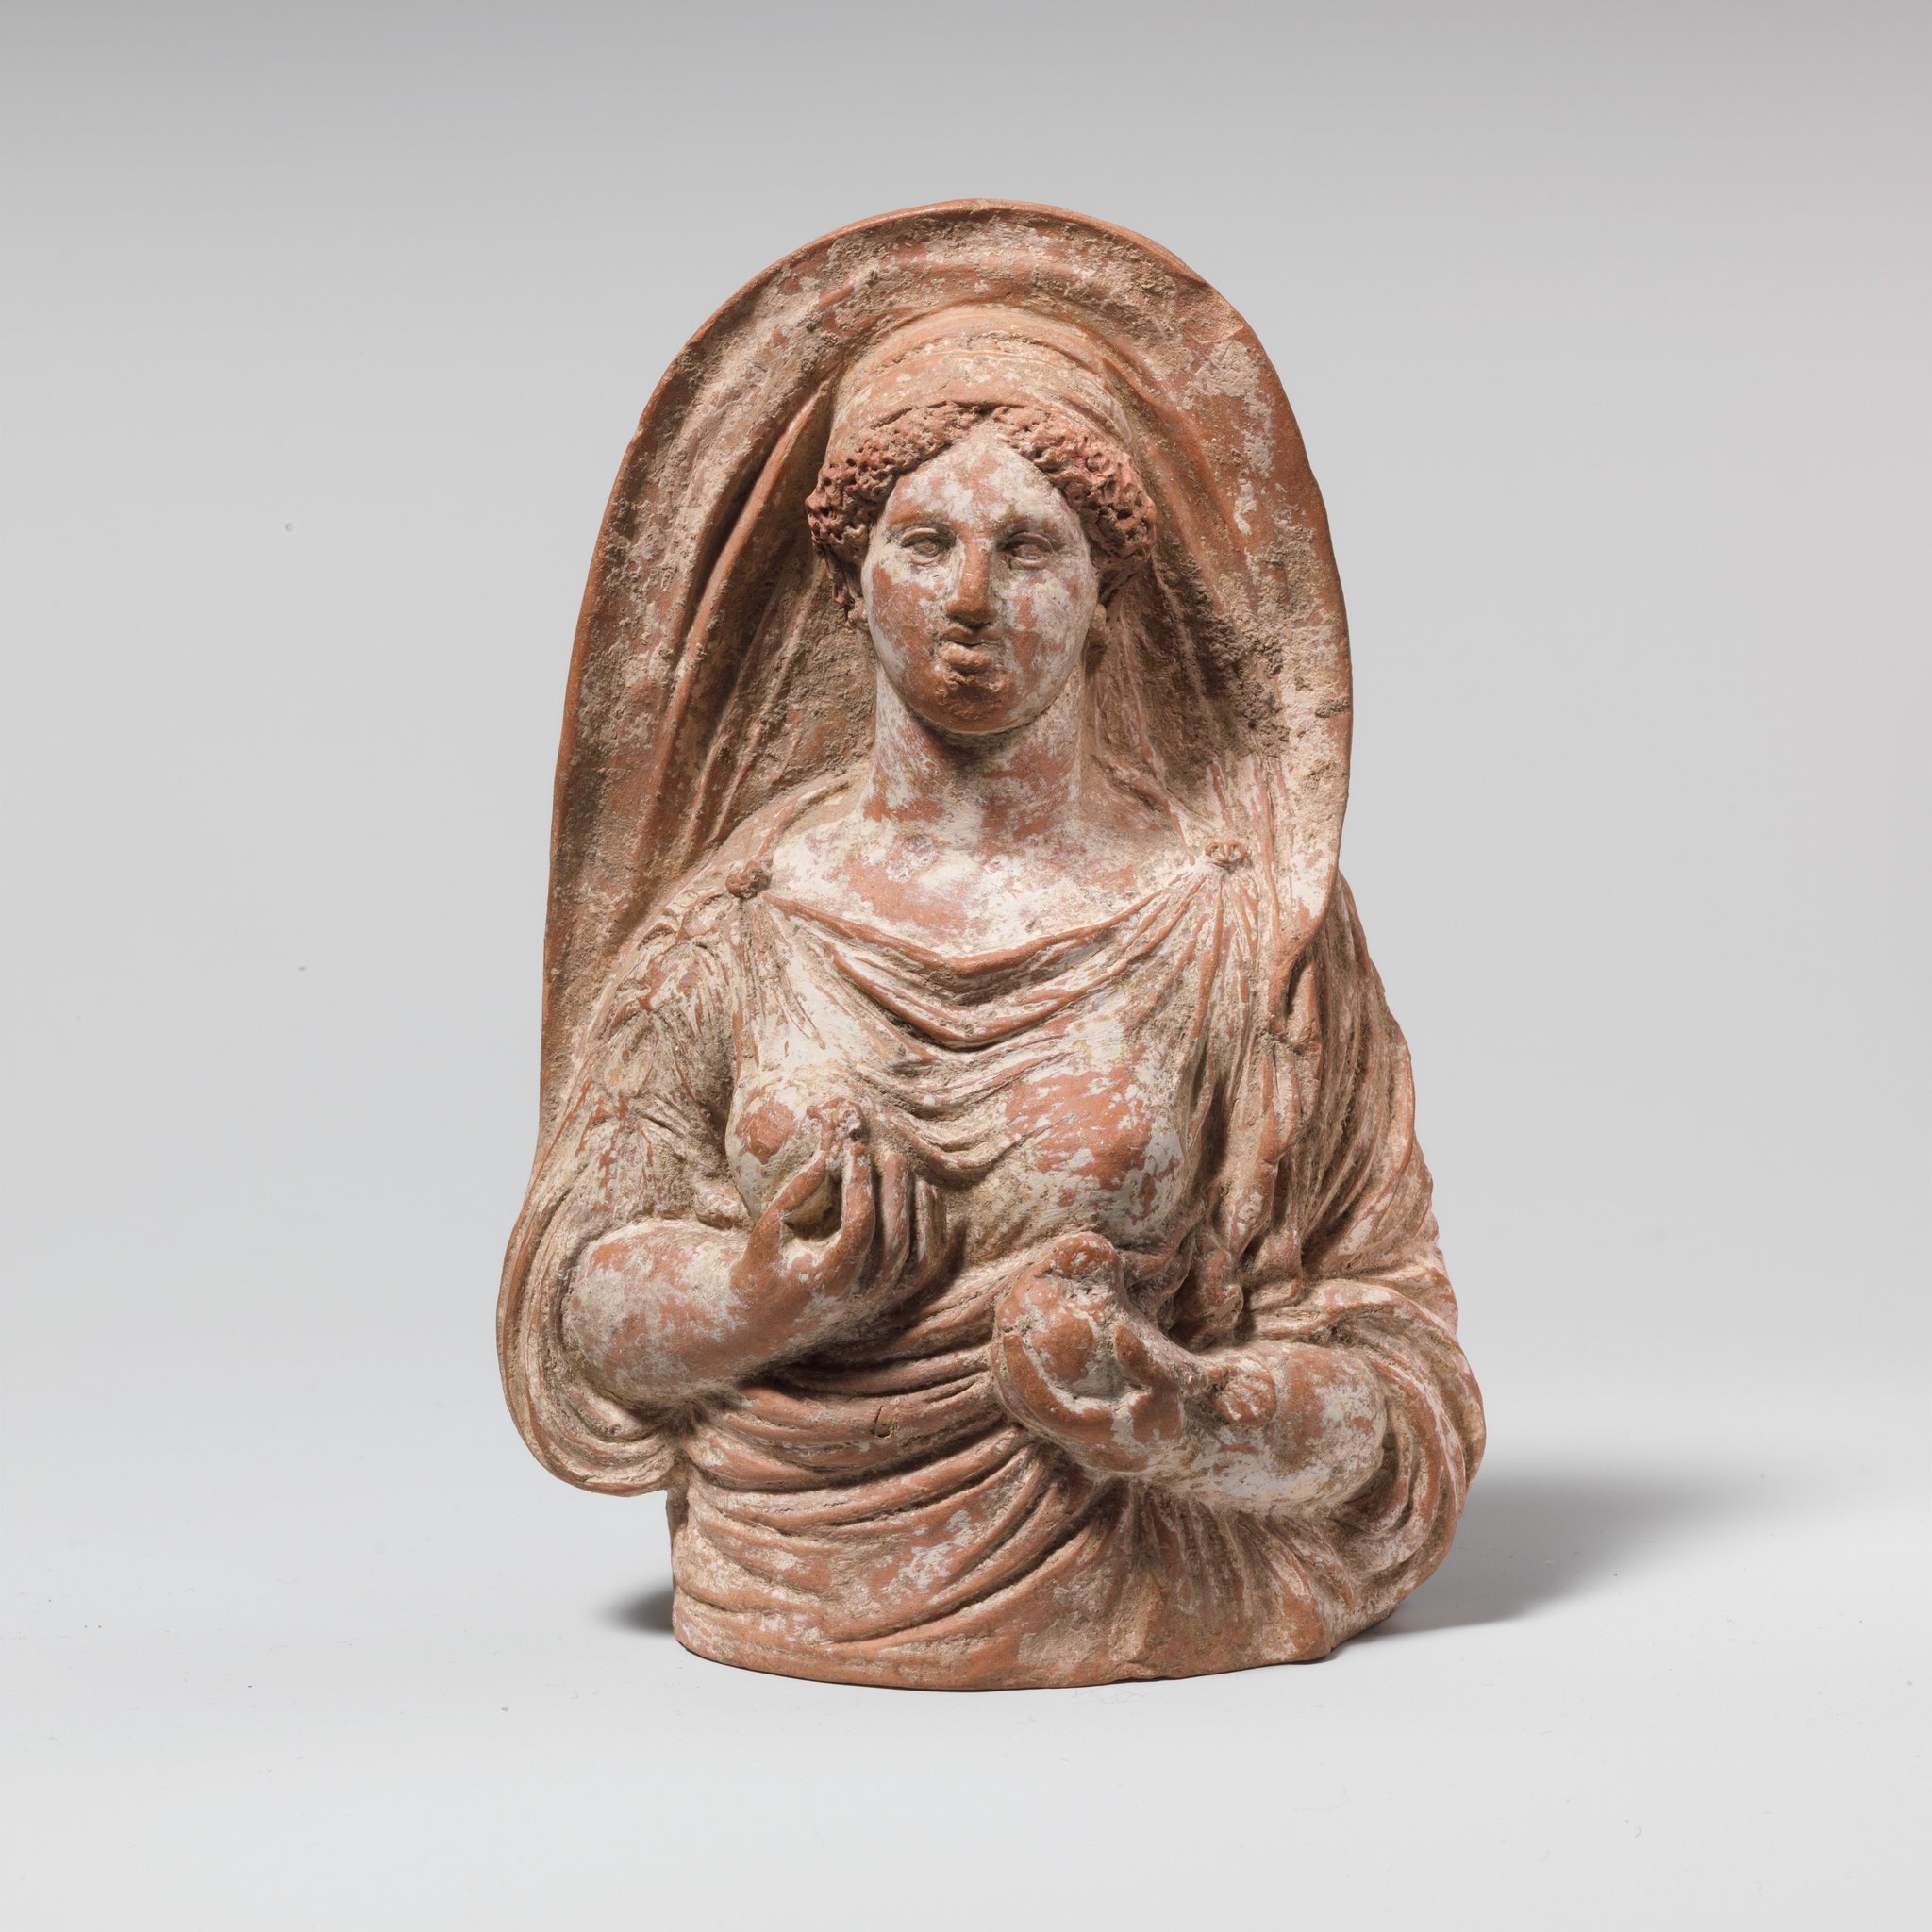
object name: mask of a woman to hip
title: Terracotta mask of woman to hips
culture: east greek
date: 334-201 BCE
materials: terracotta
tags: doves,masks,women